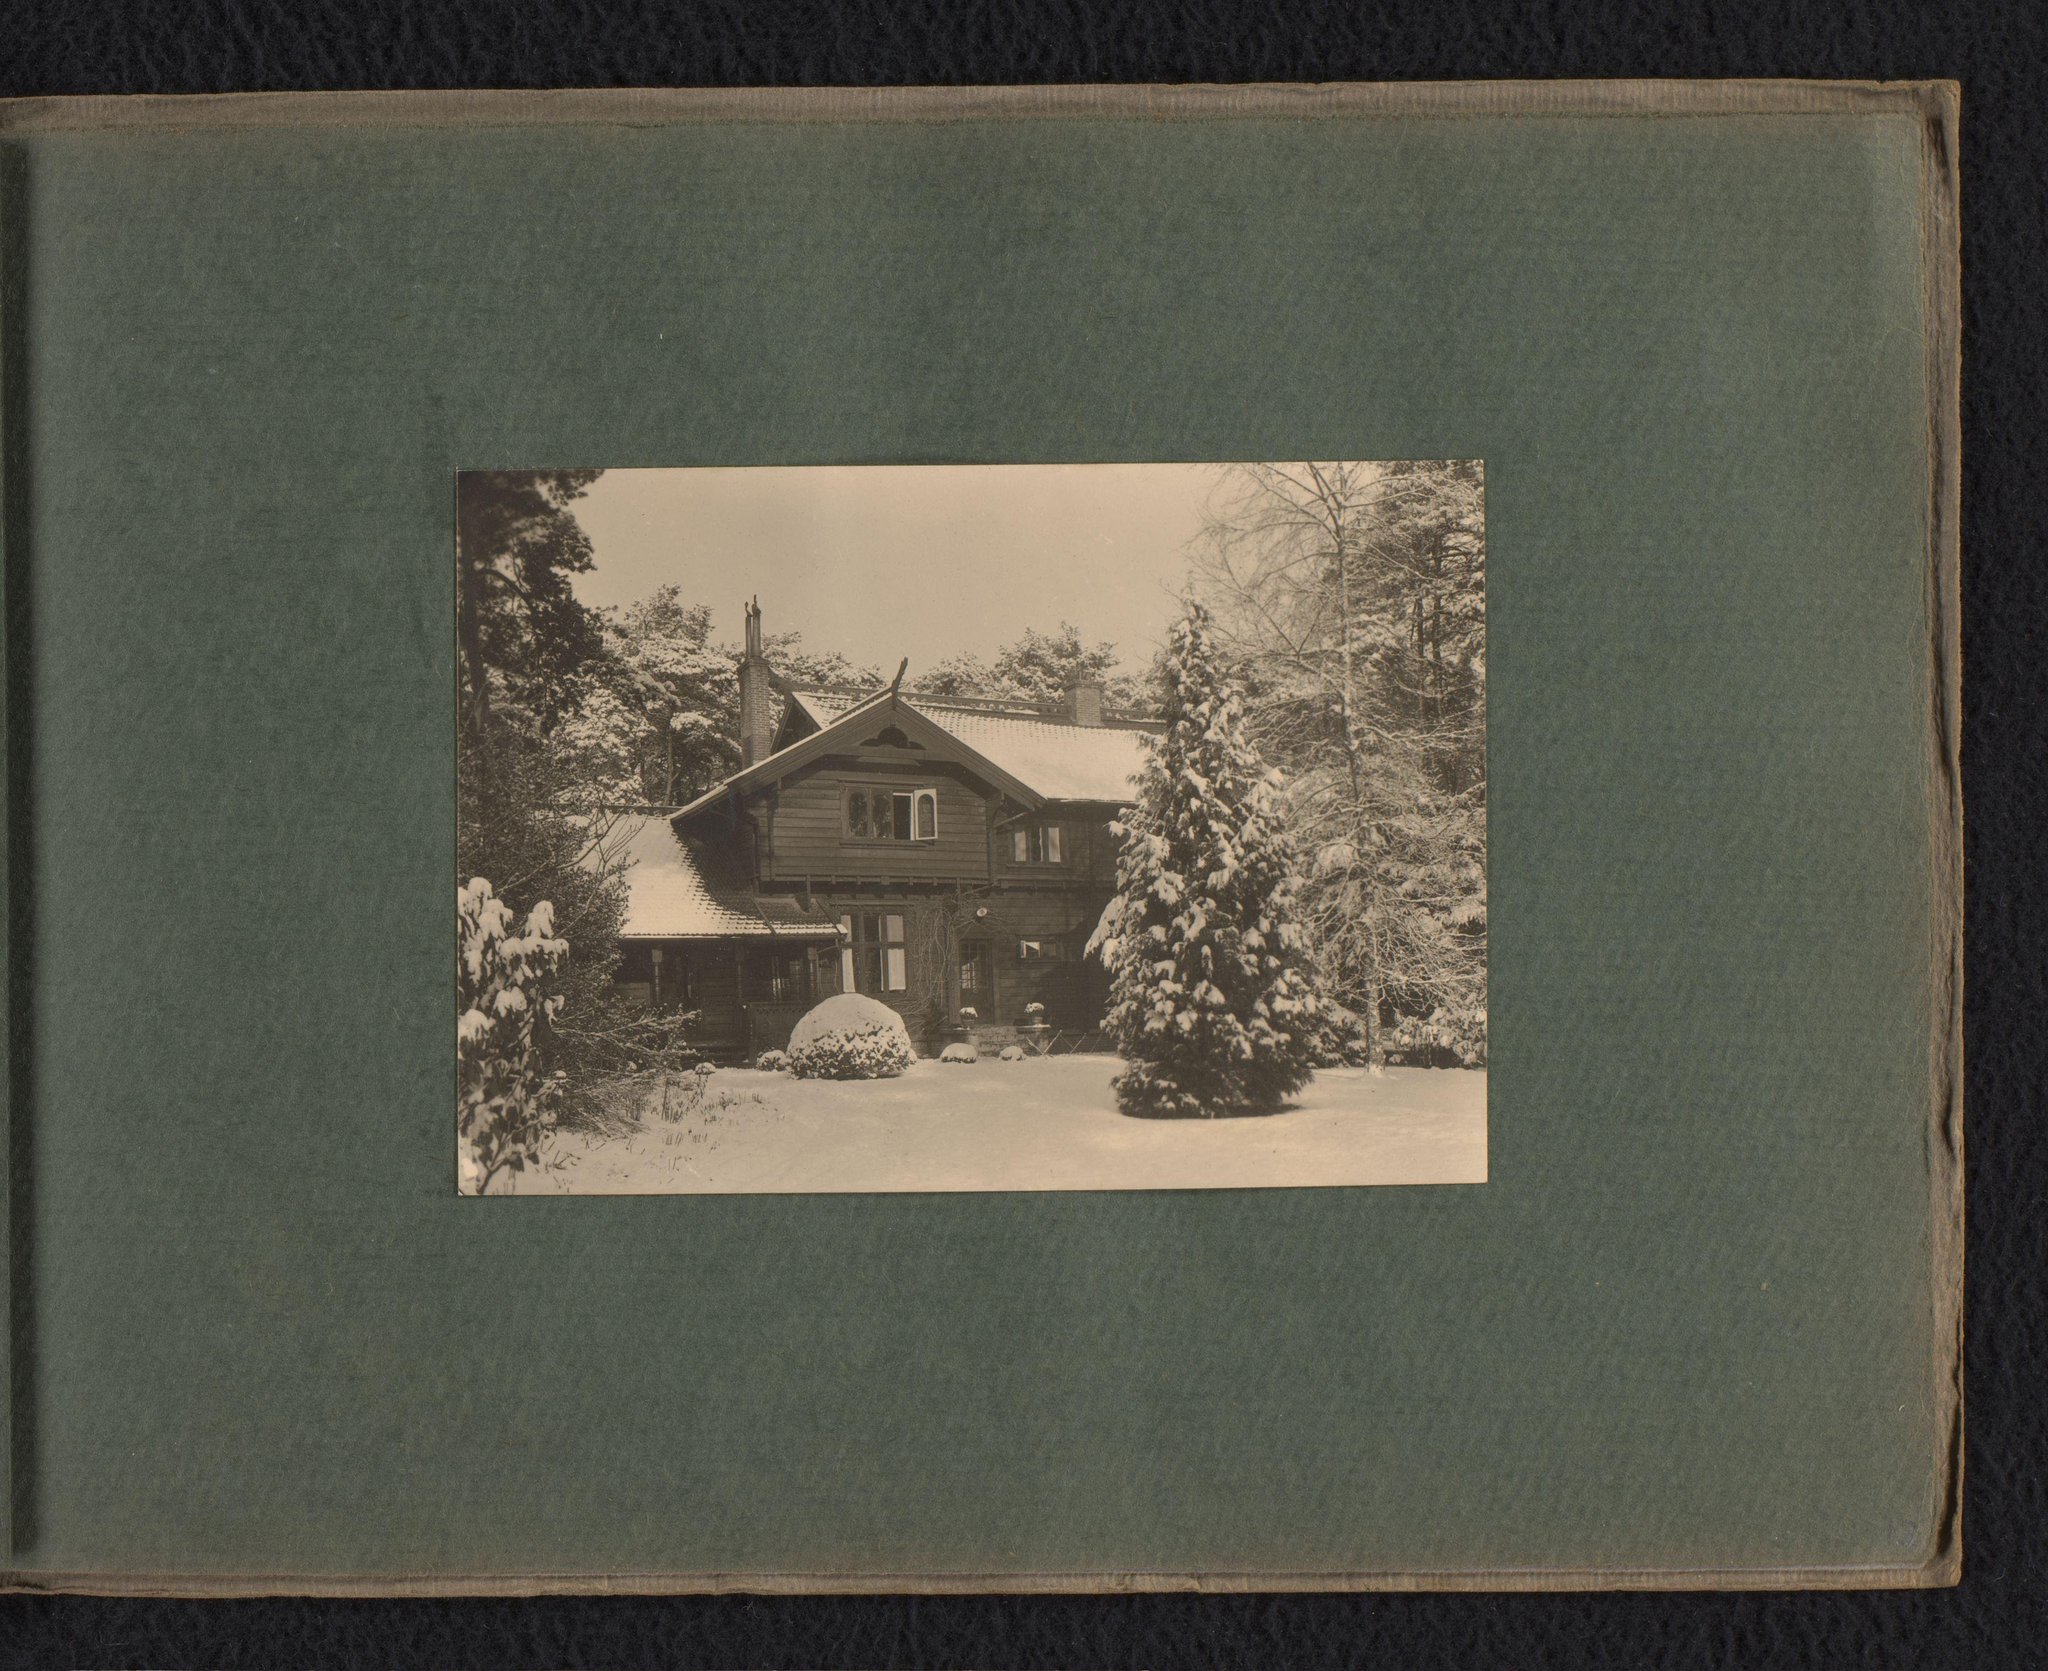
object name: photograph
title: Exterieur van een chalet in de sneeuw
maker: Anonymous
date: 1920-1930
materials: paper, cardboard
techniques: gelatin silver print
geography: europe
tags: exterior ~ representation of a building